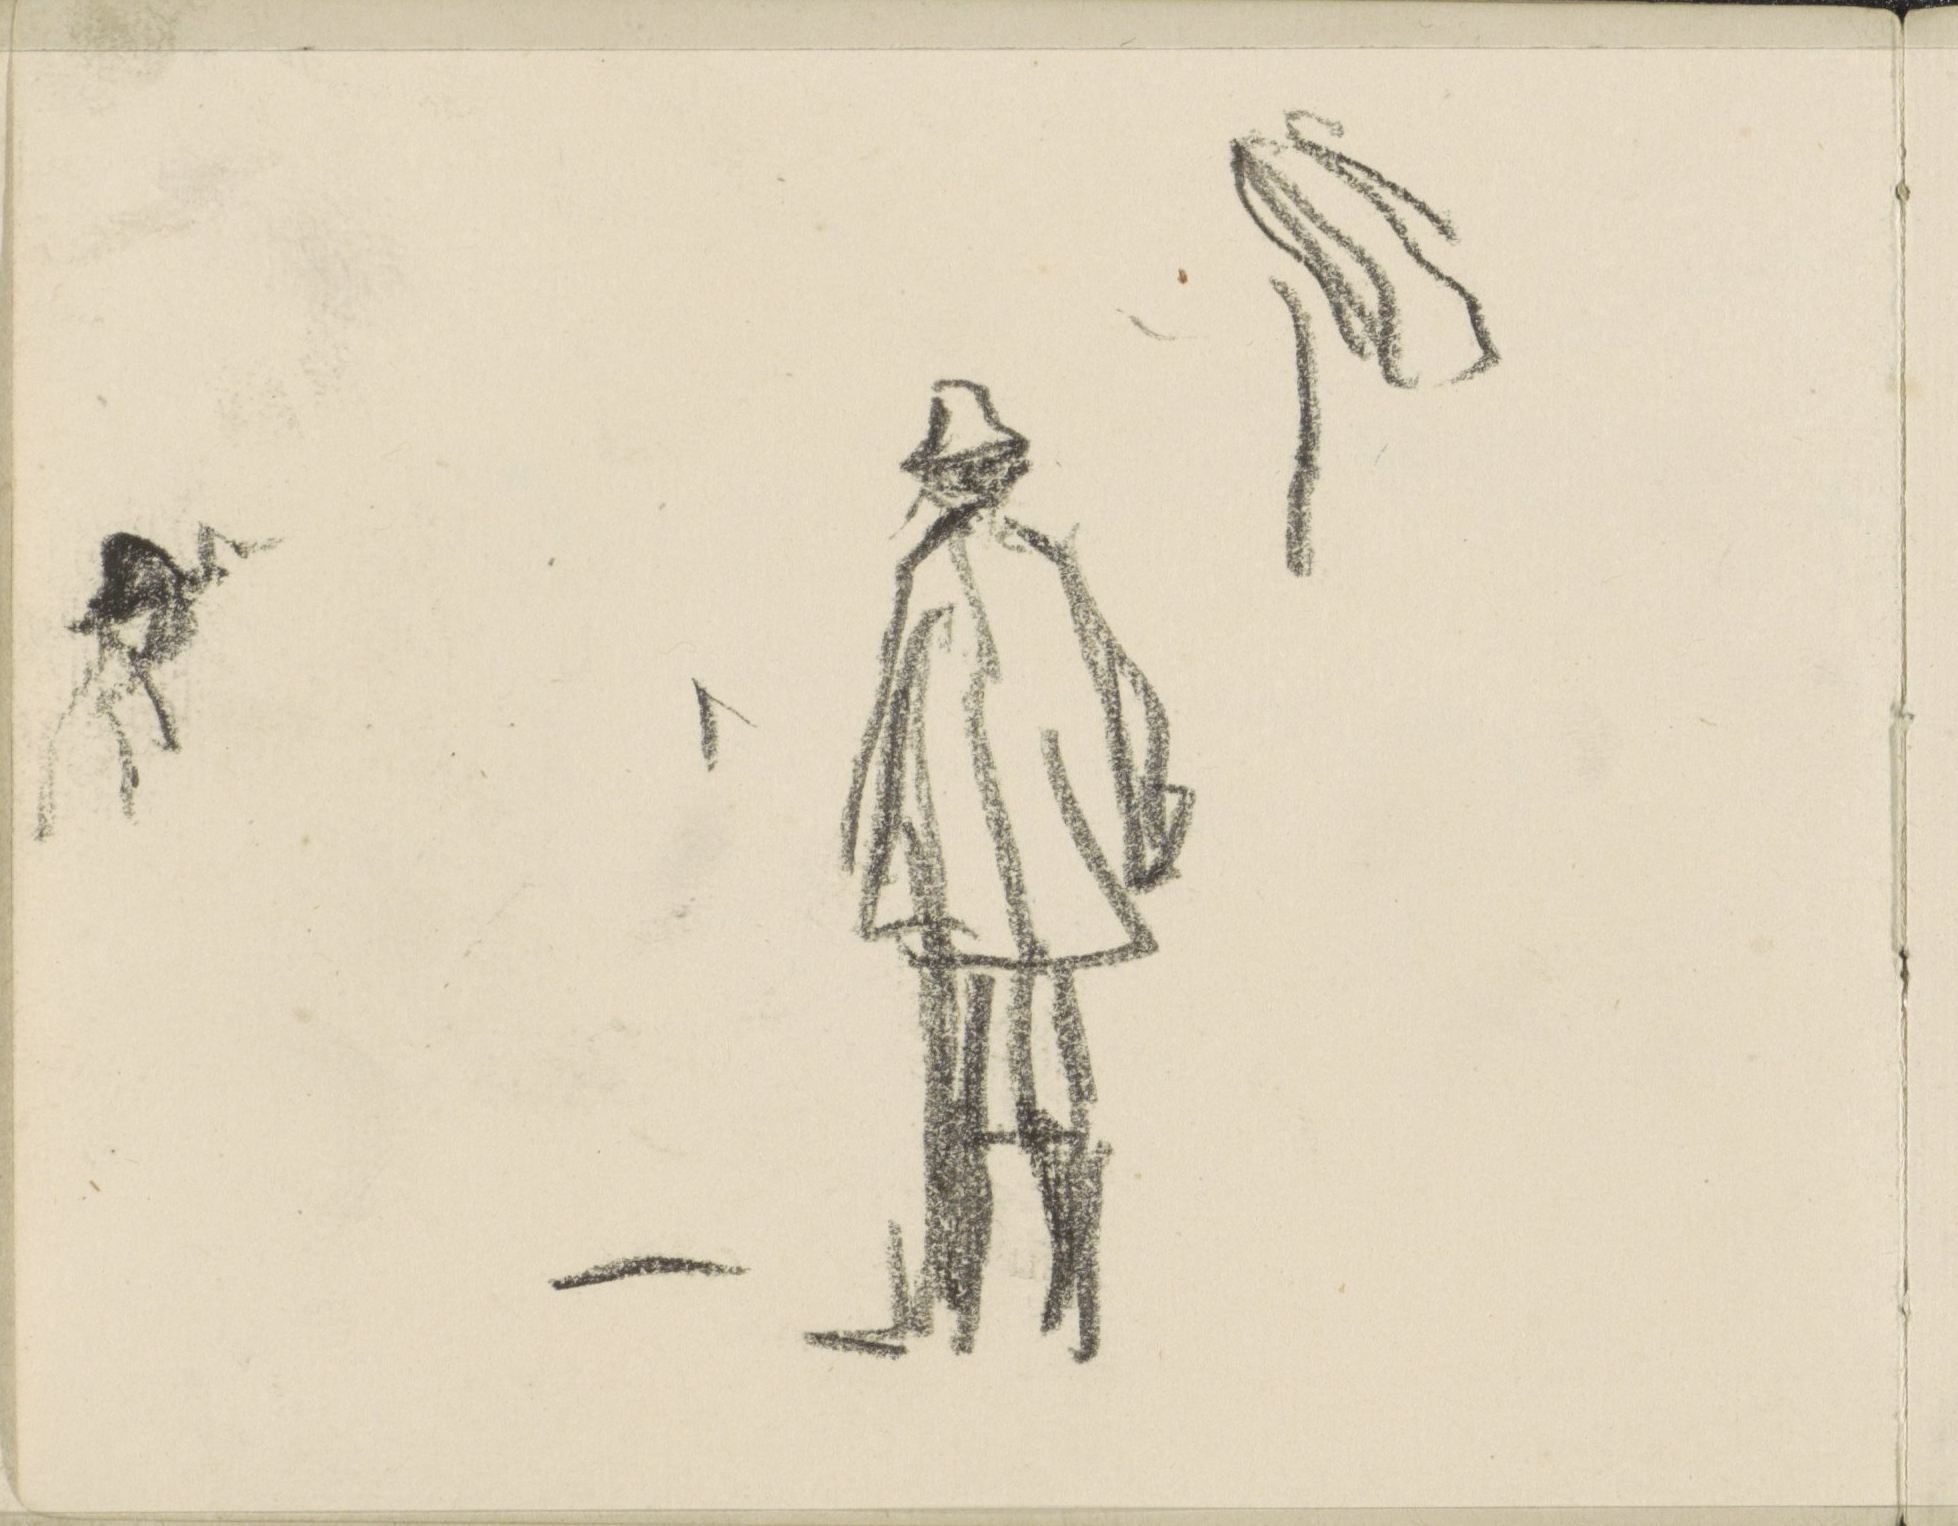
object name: sketchbook leaf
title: Figuurstudies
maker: george hendrik breitner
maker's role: draughtsman, painter, print maker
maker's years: 1857-1923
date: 1893-1899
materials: chalk, paper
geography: amsterdam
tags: adult woman, adult man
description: Pagina 49 uit een schetsboek met 28 bladen.